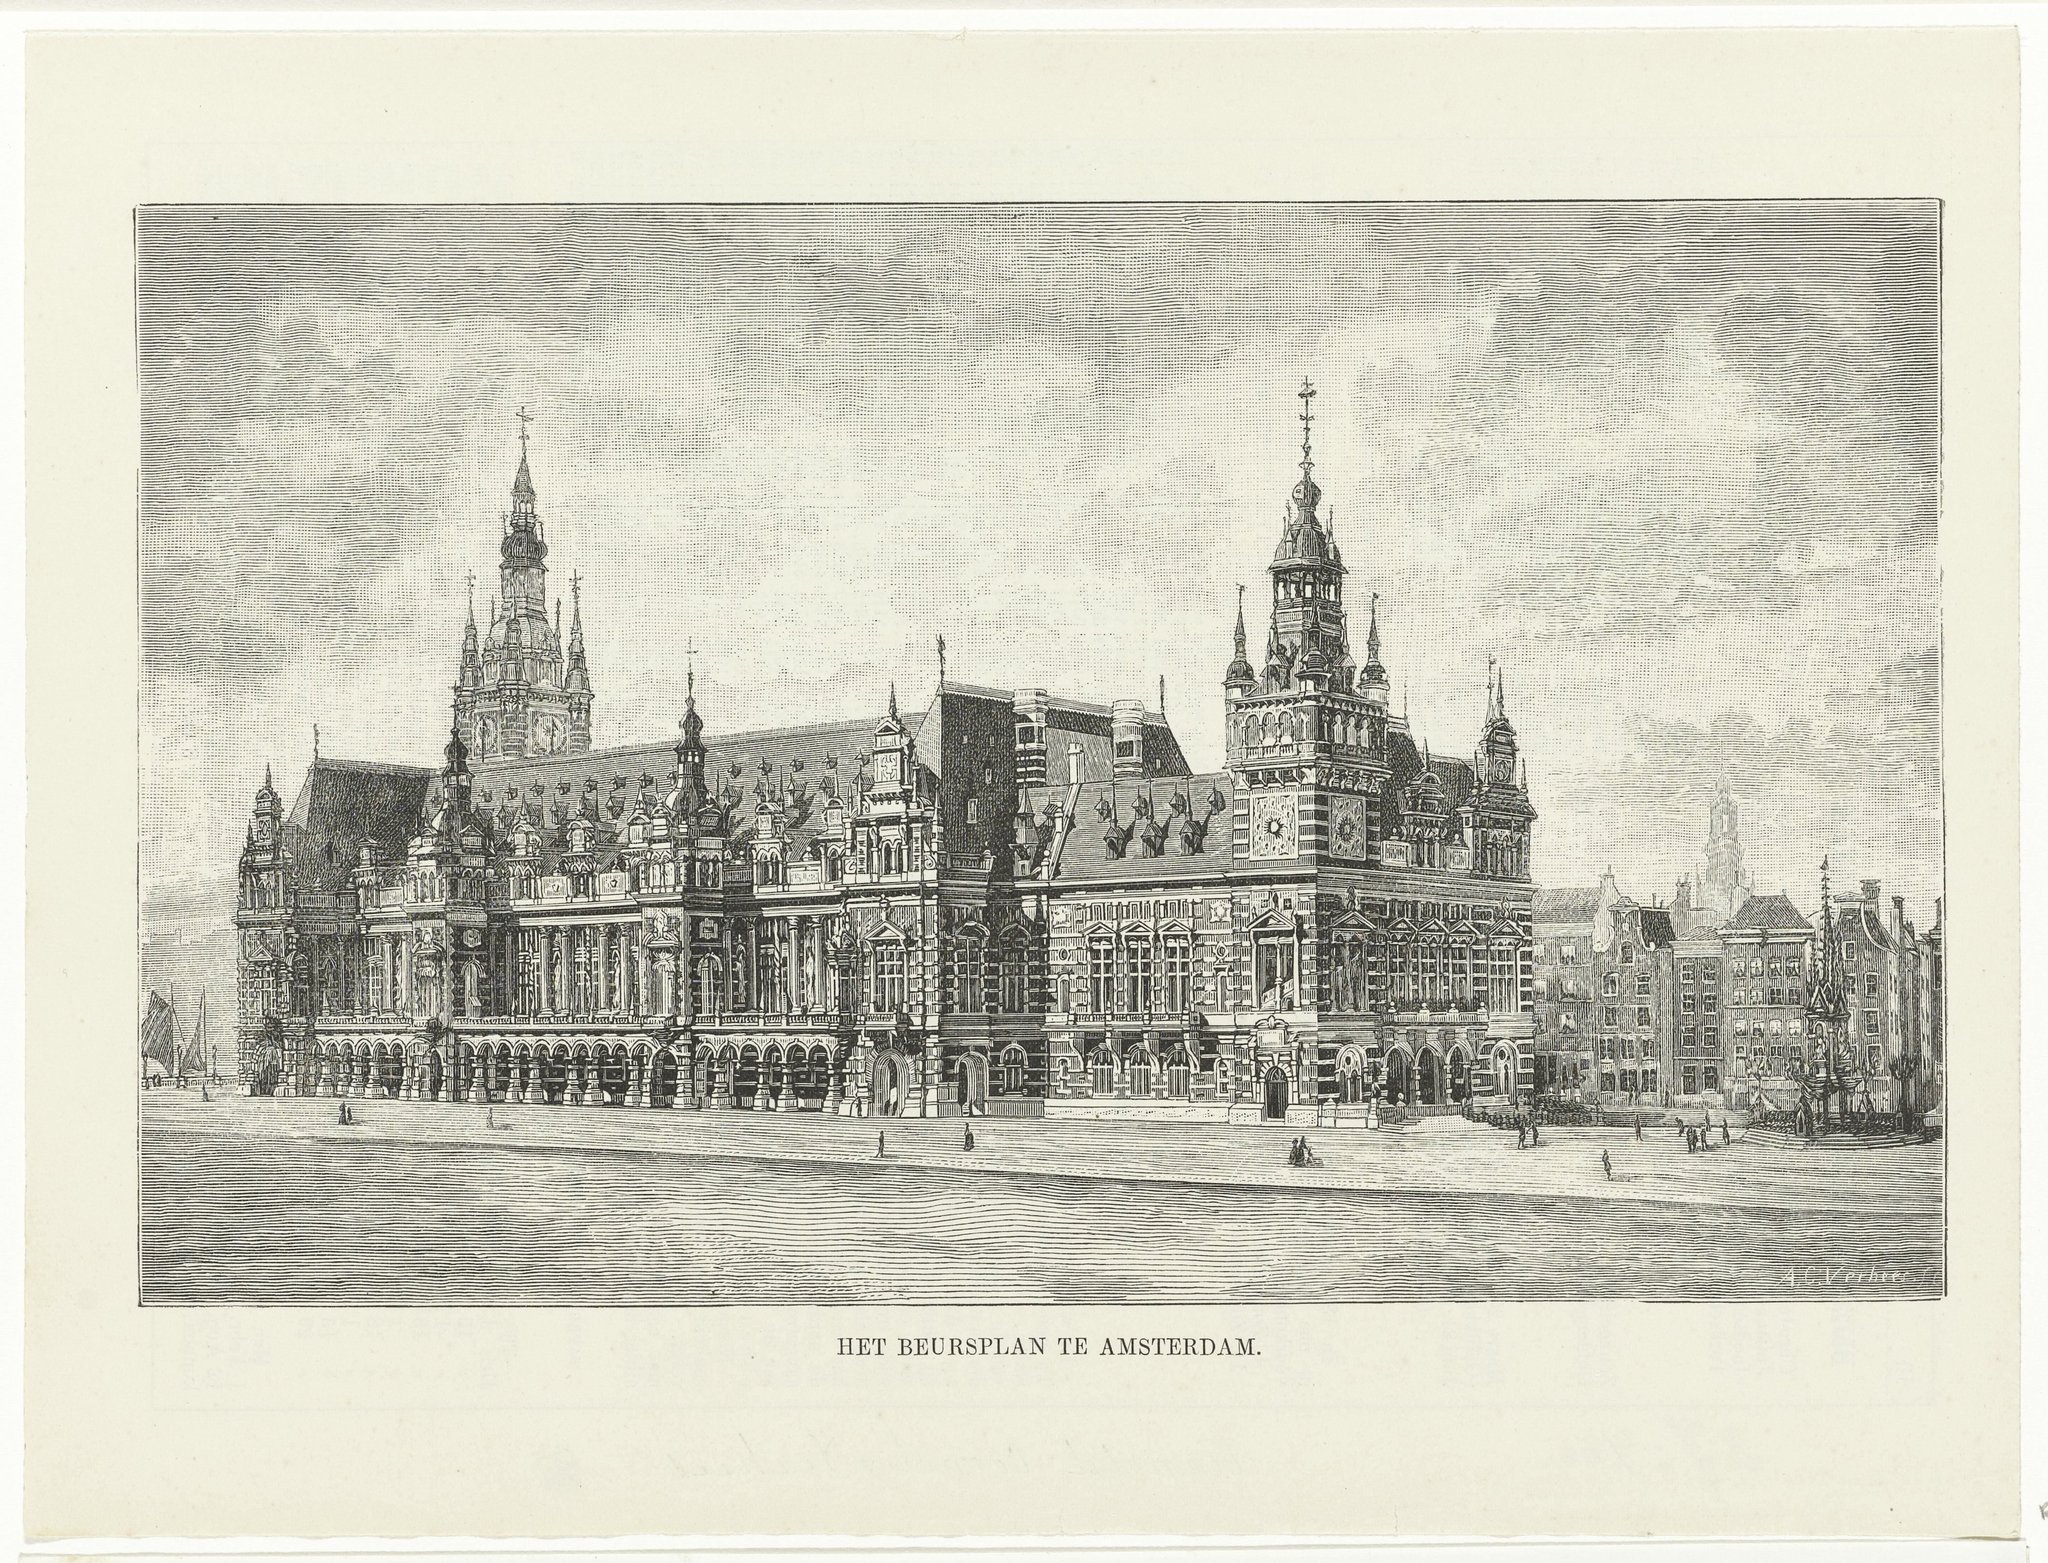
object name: print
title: Het Beursplan te Amsterdam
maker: arnoldus cornelius verhees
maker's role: print maker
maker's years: 1859-1929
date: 1869-1929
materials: paper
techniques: letterpress printing, engraving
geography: den bosch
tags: stock exchange, stock-market, square, place, circus, etc. (+ city(-scape) with figures, staffage), amsterdam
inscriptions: collector's mark: Lugt 2228, collector's mark: Lugt 2760